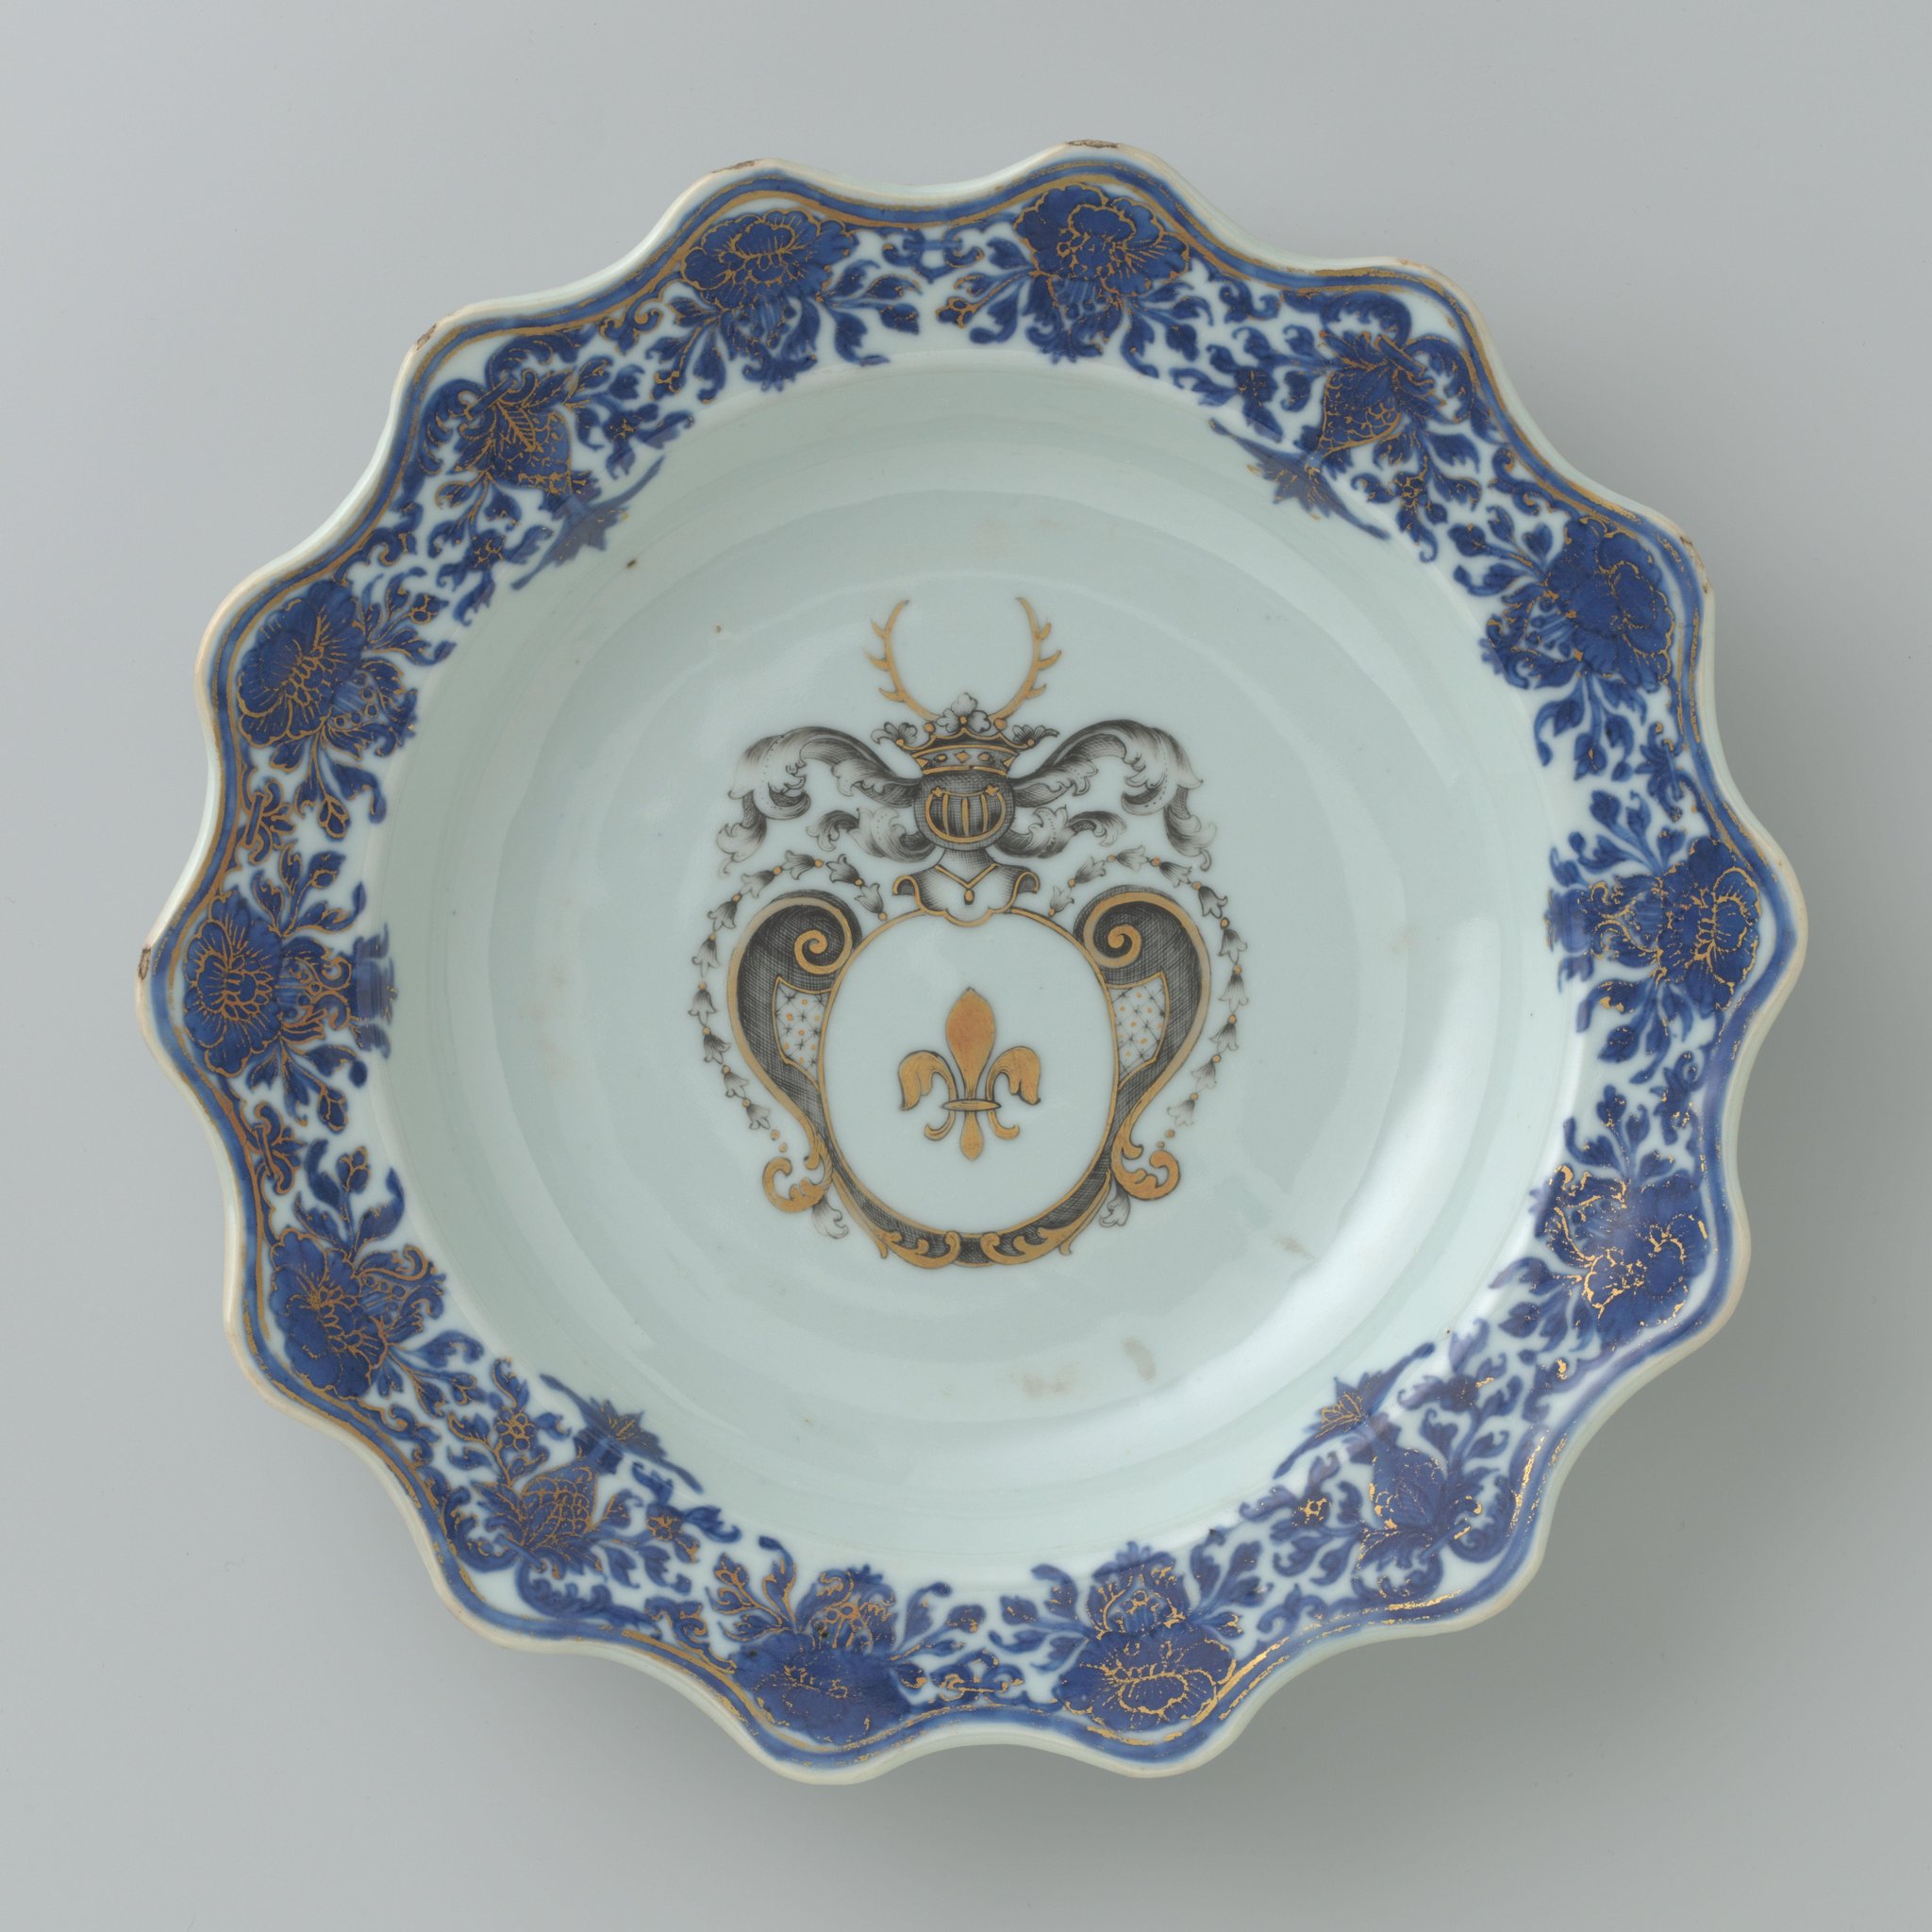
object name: soup plate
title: Soepbord met het wapen van de familie Swellengrebel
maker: Anonymous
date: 1740-1750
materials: cobalt, glaze, gold, paint, porcelain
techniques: firing, gilding, turning, vitrification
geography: china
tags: utrecht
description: Soepbord op een standring en met een golvende rand. Beschilderd in onderglazuur blauw en met zwart en goud op het glazuur. Rond de rand een brede band met bandwerk en bloemranken in blauw met goud. In het centrum het wapen van de familie Swellengrebel in zwart en goud: Franse lelie op een ovaal schild en een gewei boven een kroon als helmteken. Wapenporselein in blauw-wit en emailkleuren.